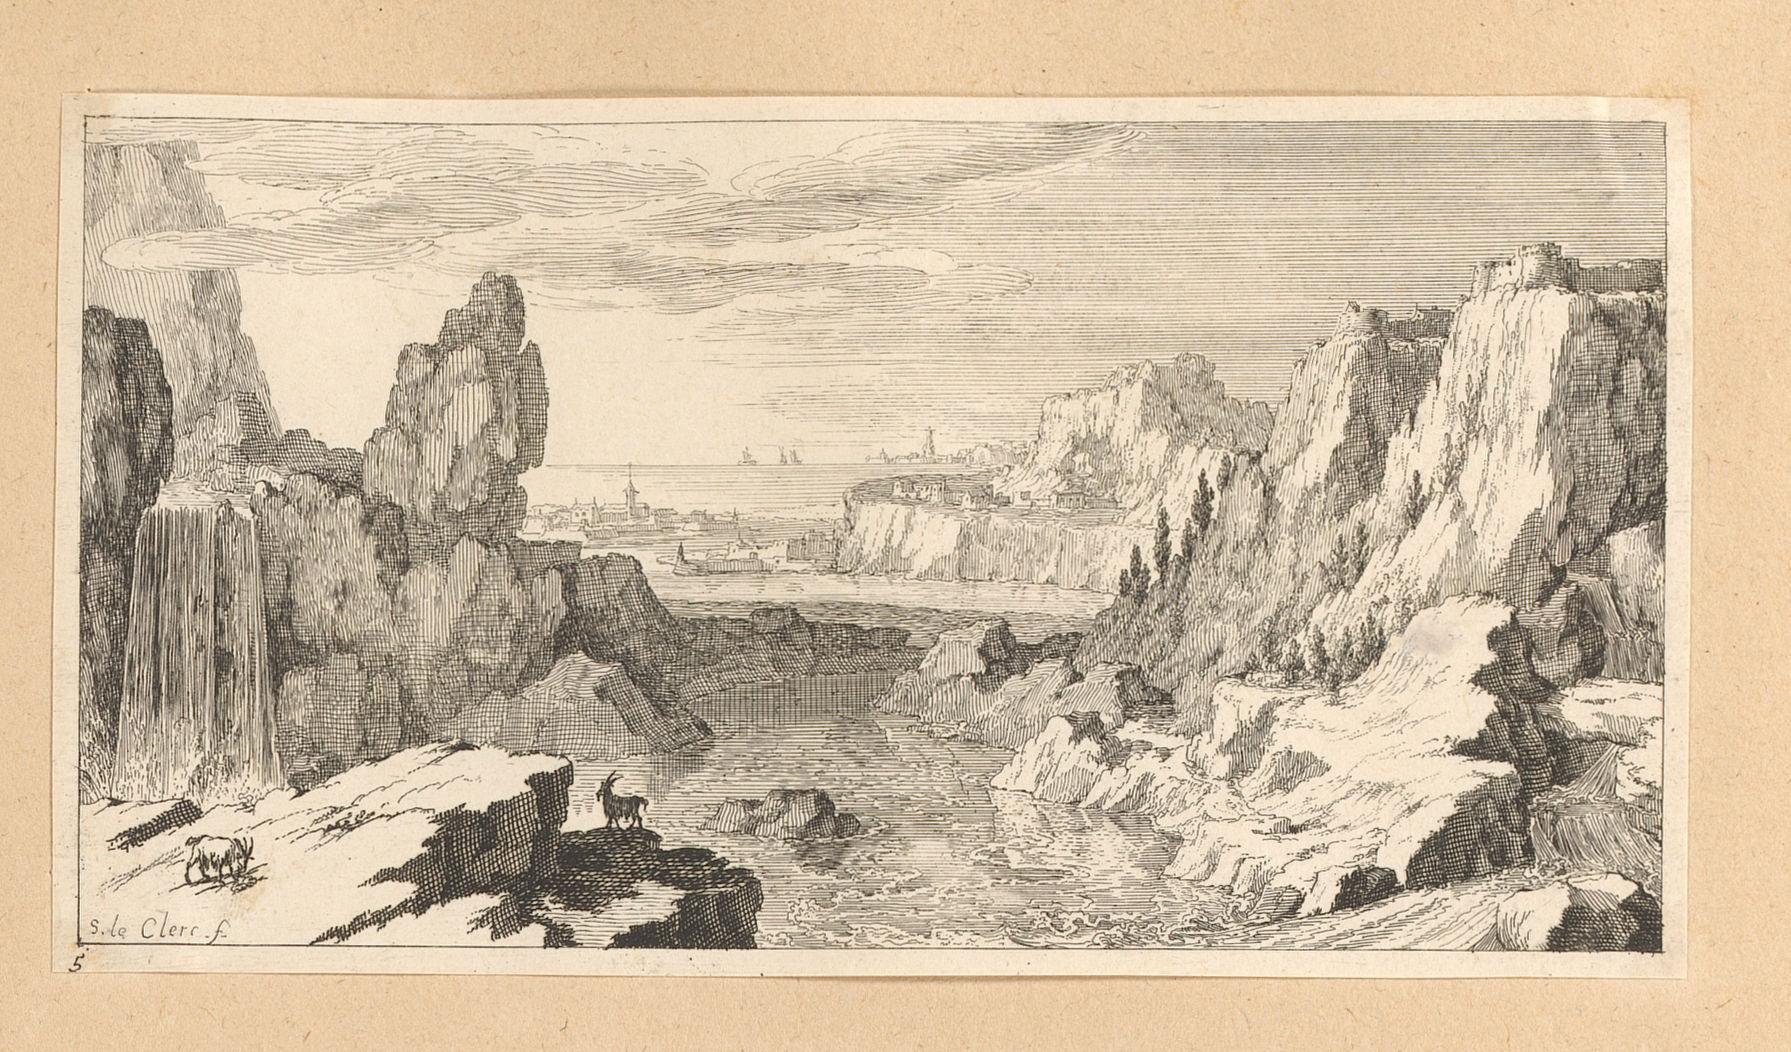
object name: album leaf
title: Berglandschap met op de achtergrond een dorp aan de kust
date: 1693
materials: paper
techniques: etching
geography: paris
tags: rocky coast, goat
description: Maakt deel uit van een twaalfdelige serie met landschappen en gezichten op verschillende gebouwen. Een eerste editie werd uitgegeven door Nicolas Langlois in 1693 en een tweede in 1784 door Lamy.